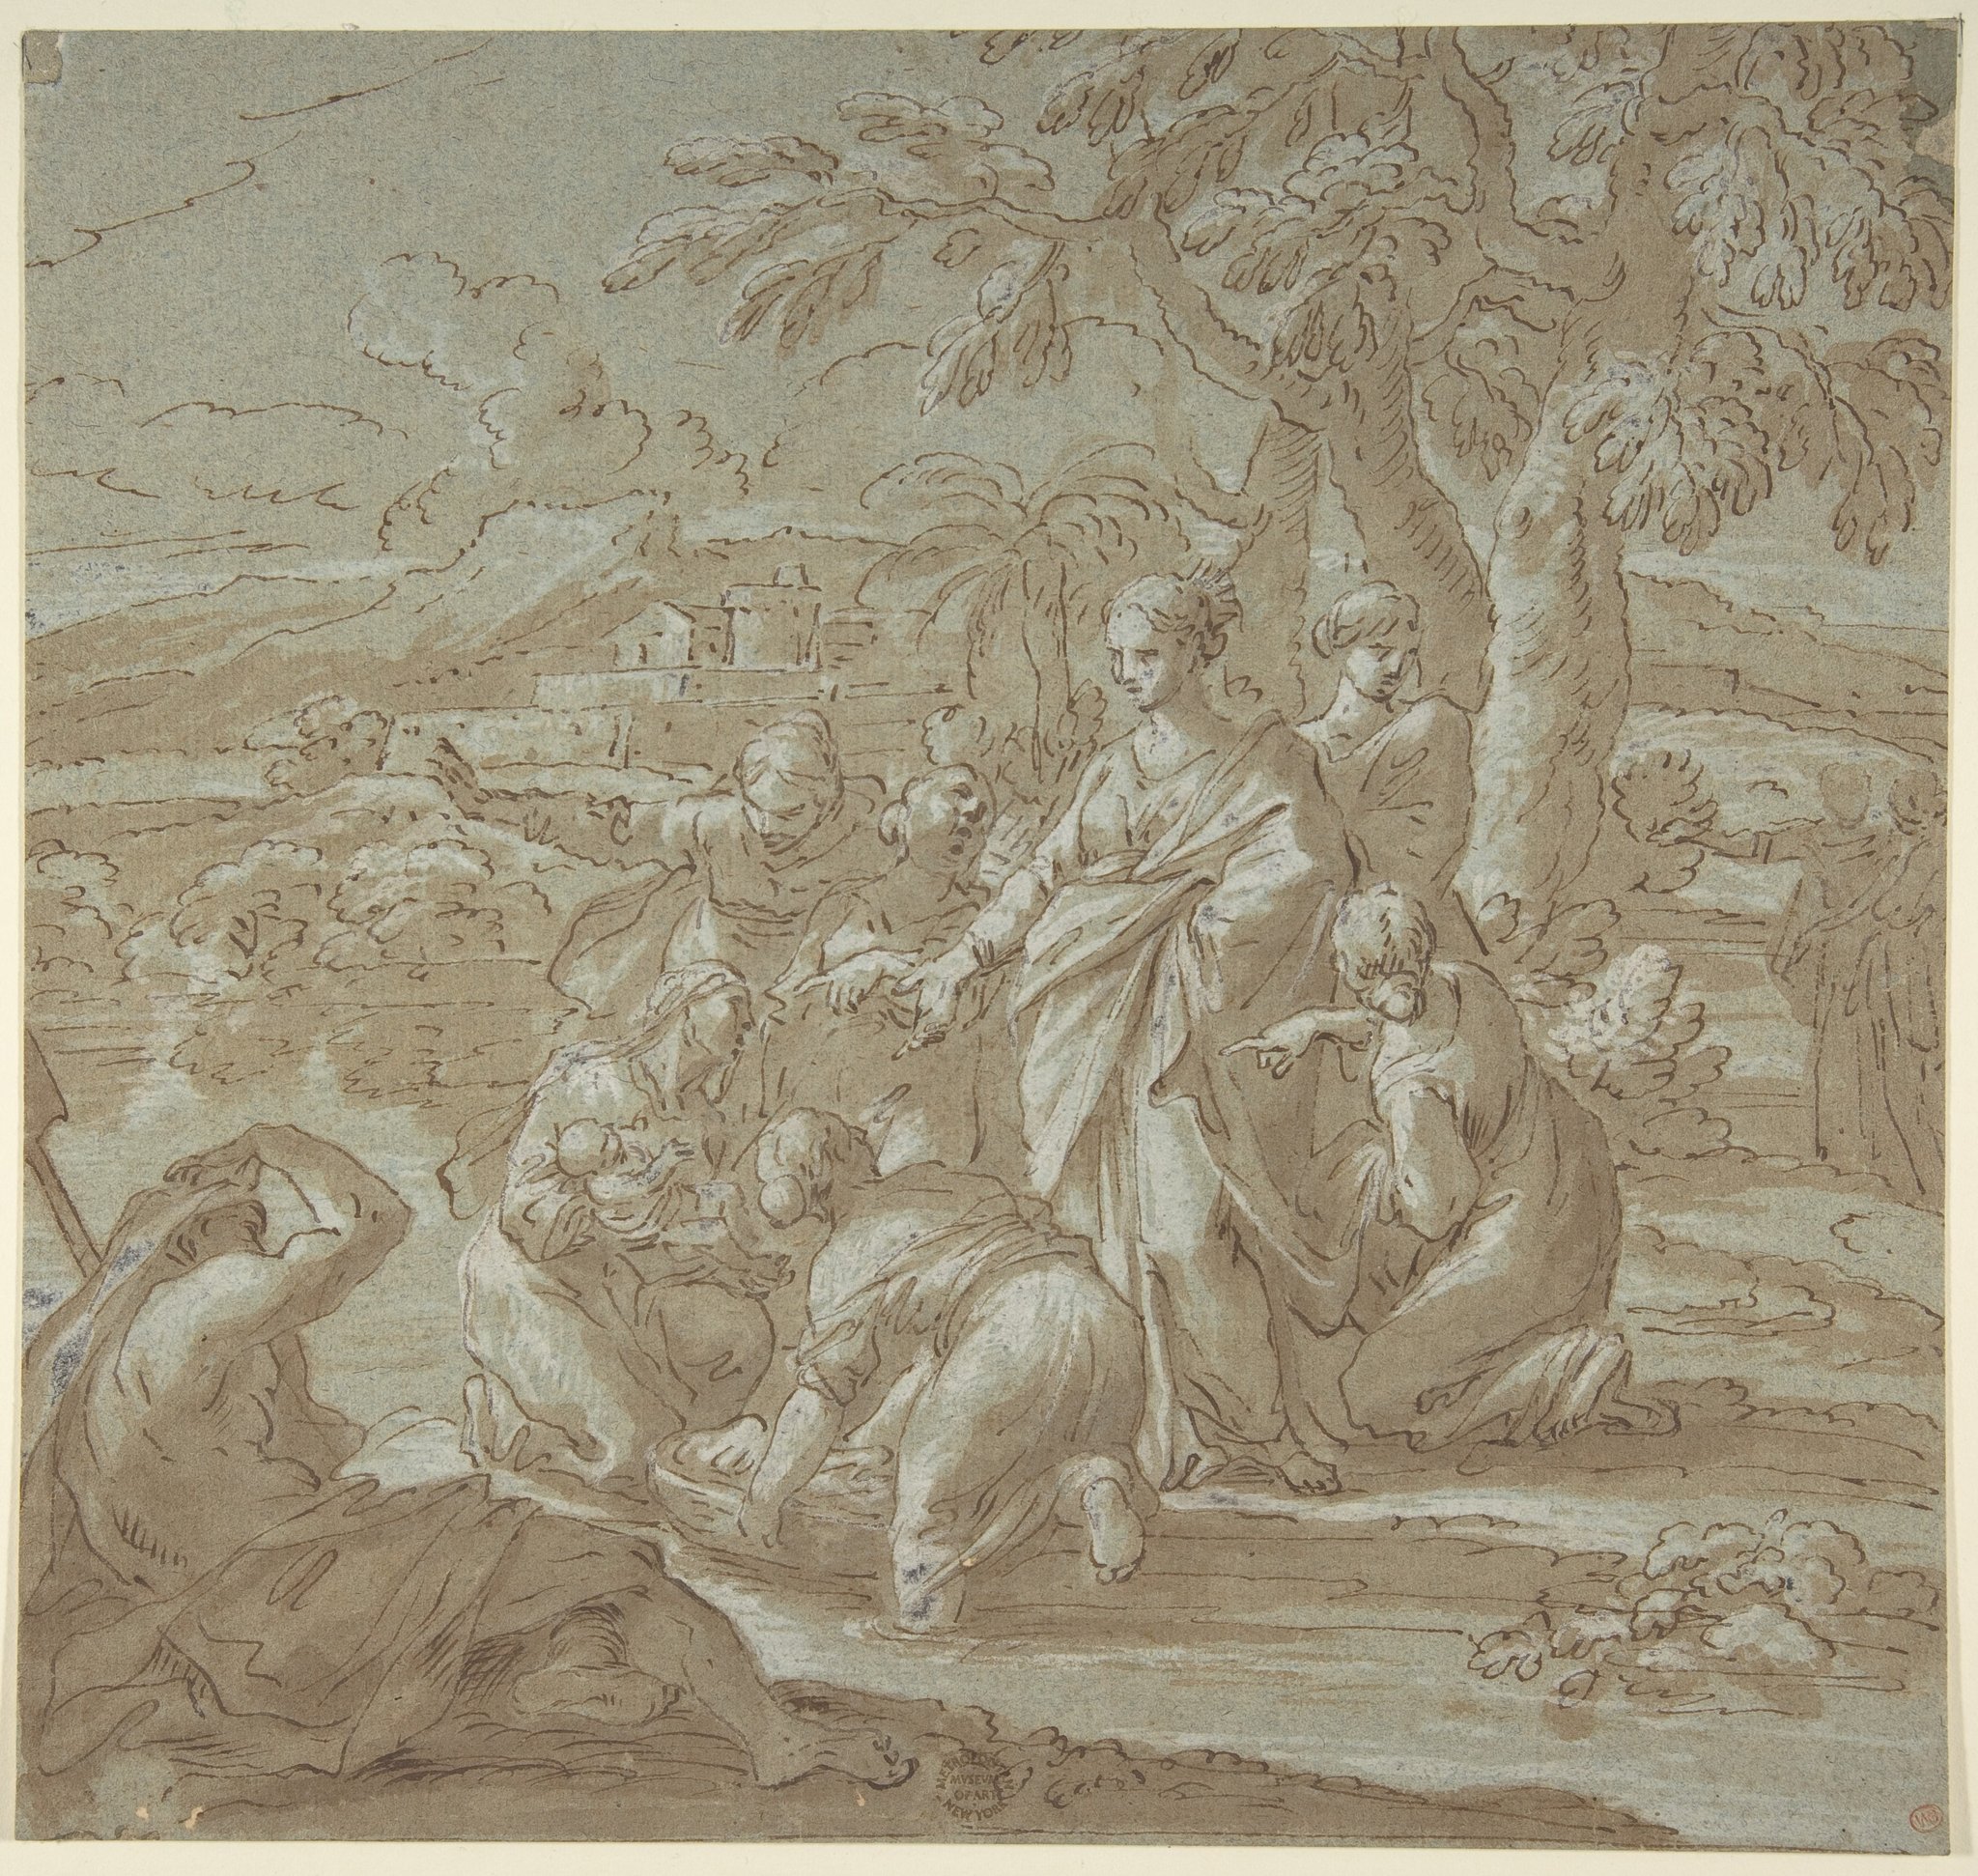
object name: drawing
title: The Finding of Moses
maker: luigi garzi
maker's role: artist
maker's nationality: italian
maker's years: 1638-1721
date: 1638-1721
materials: ink, paper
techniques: brush, highlighting, pen, wash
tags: men,women,trees,moses